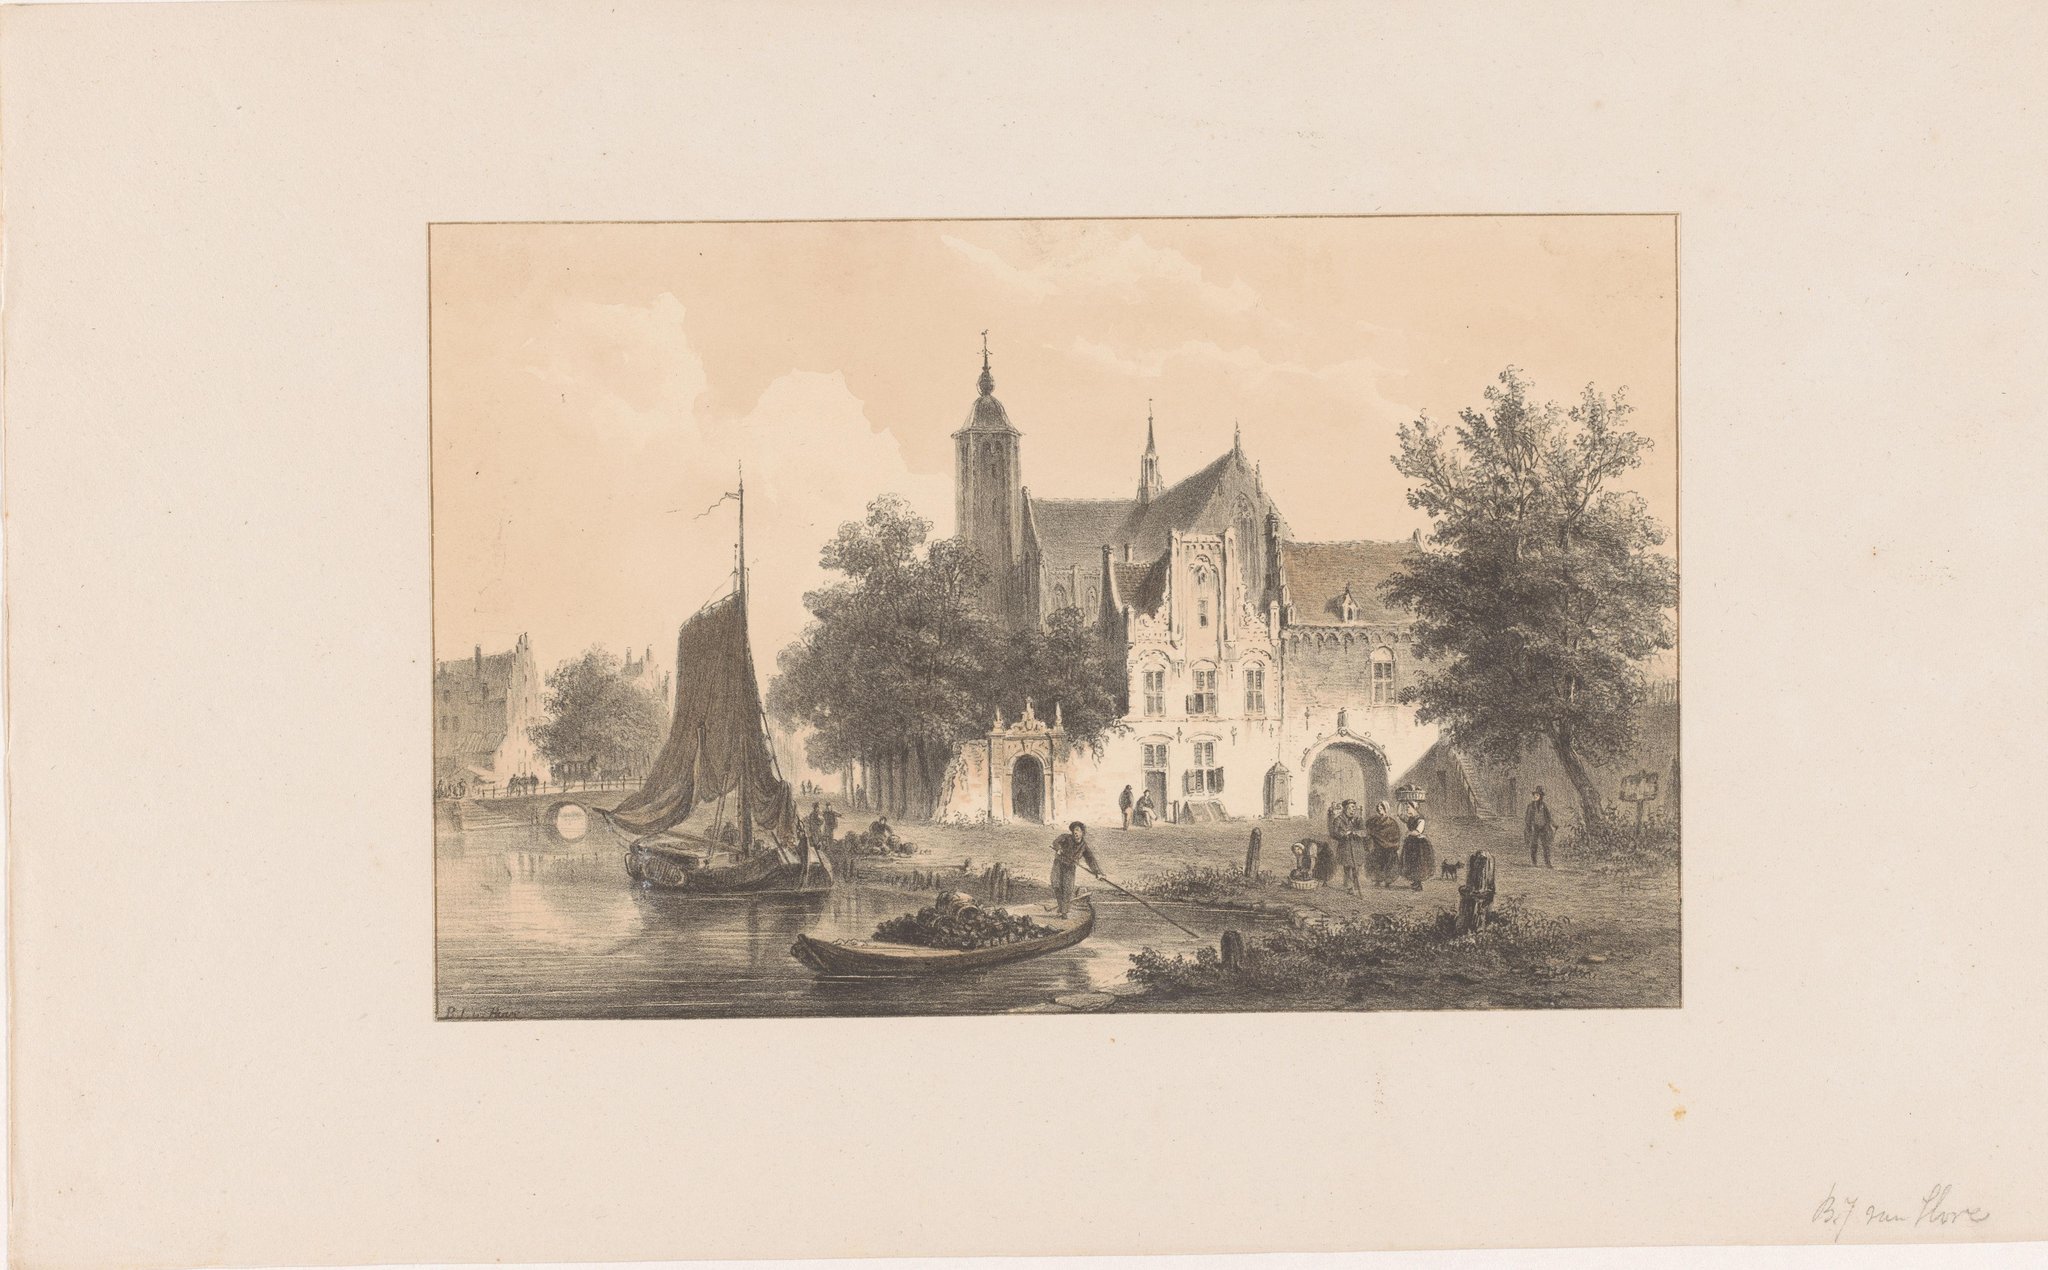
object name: print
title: Stadsgezicht met rivier en kerk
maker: bartholomeus johannes van hove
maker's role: draughtsman, painter, print maker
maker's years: 1790-1880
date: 1847-1863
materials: paper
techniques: tone lithography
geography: netherlands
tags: sailing-ship, sailing-boat, church (exterior), city-view, and landscape with man-made constructions (+ city(-scape) with figures, staffage)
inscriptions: collector's mark: Lugt 2228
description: Op het water liggen een zeilboot en een punter.